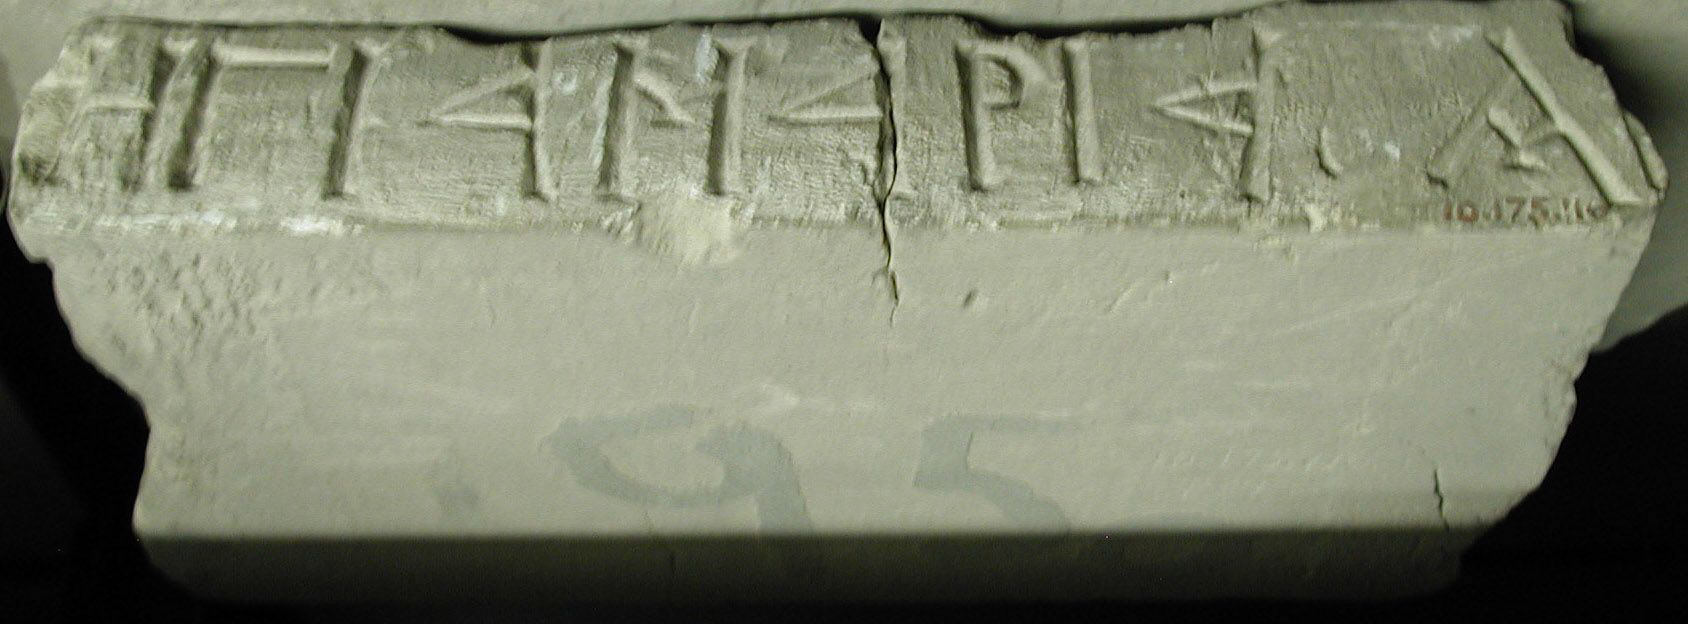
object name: fragment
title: Fragment of an Inscribed Block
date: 501-700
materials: limestone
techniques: incising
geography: egypt